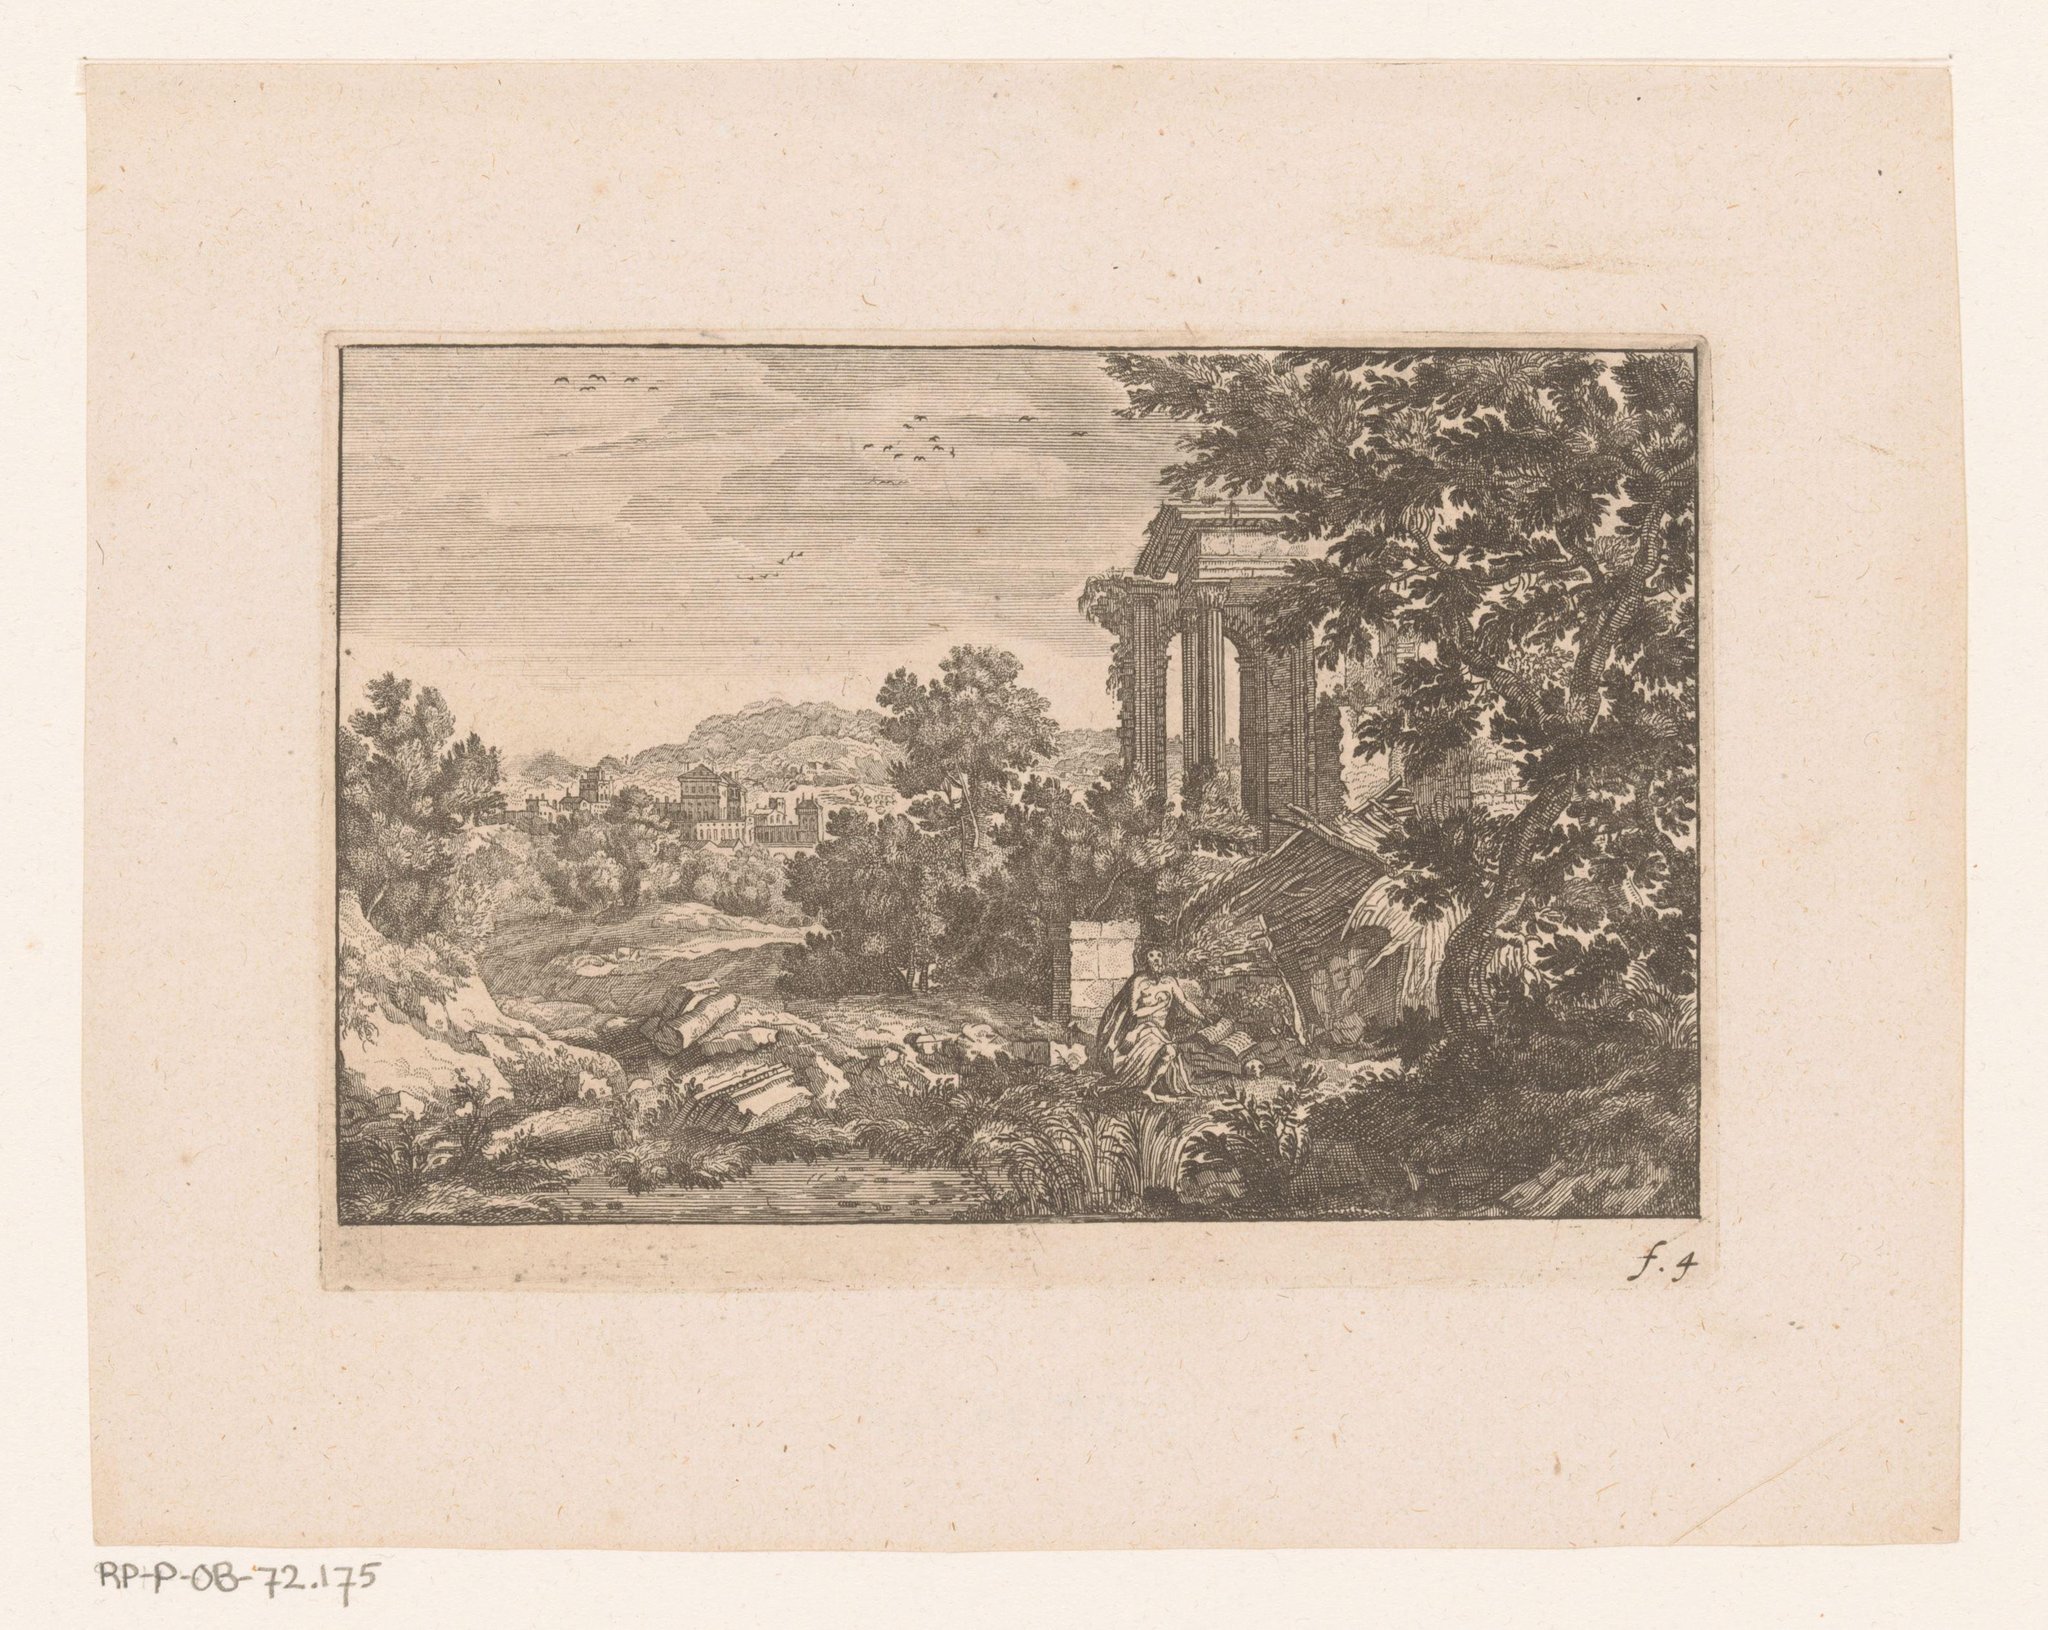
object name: print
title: Landschap met heremiet bij ruïne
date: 1613-1695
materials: paper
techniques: etching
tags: landscape with ruins, anchorite, hermit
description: Prenten met het signatuur 'Perelle' kunnen zowel door vader Gabriel als door zonen Nicolas en Adam gemaakt zijn.